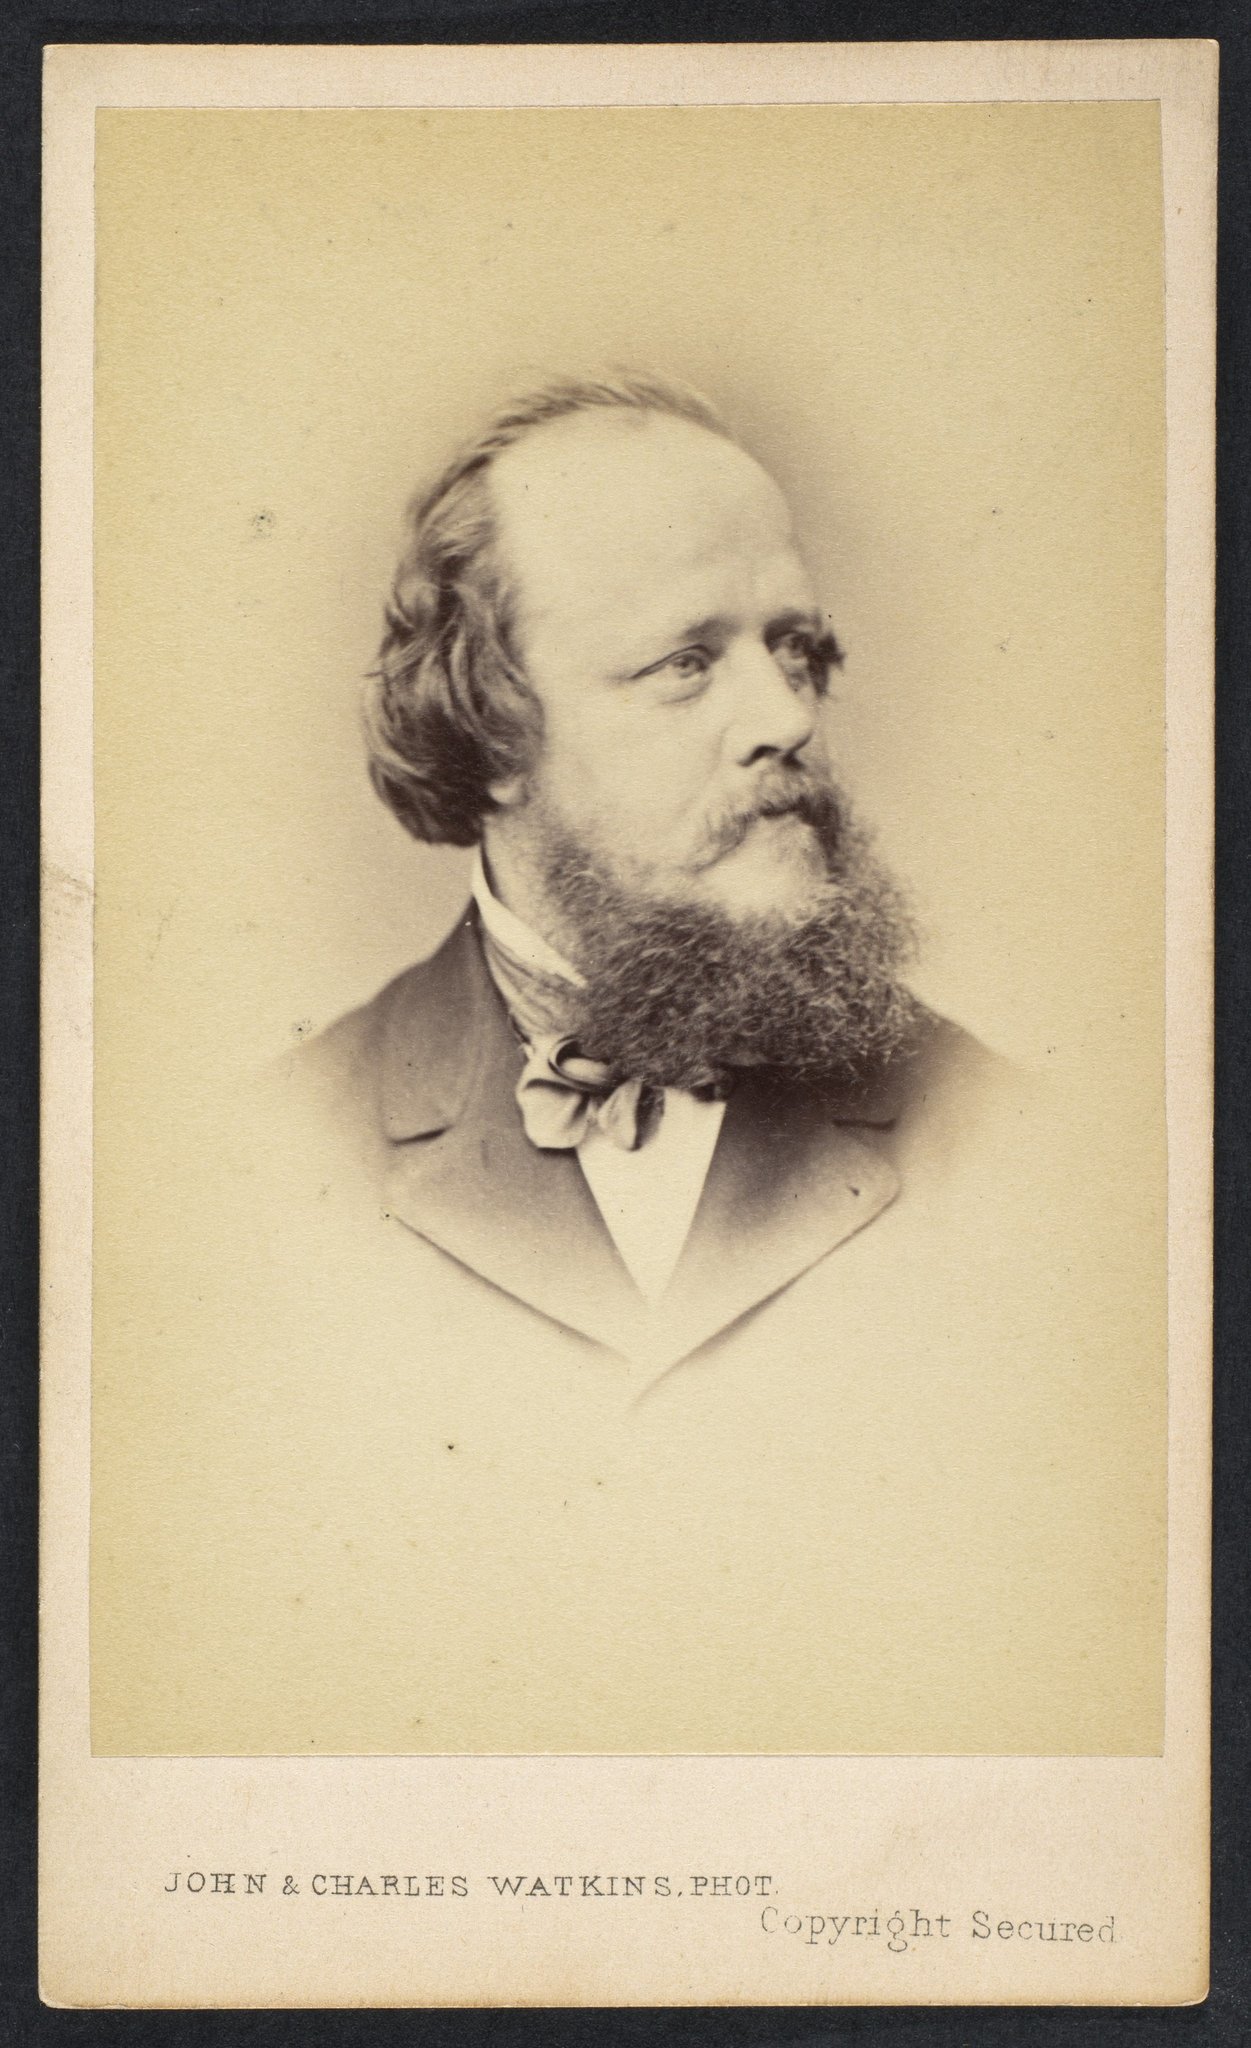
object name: carte de visite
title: [Marshall C. Claxton]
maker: john and charles watkins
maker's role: photography studio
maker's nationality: british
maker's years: 1840-1875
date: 1860-1869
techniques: albumen silver print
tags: men,portraits